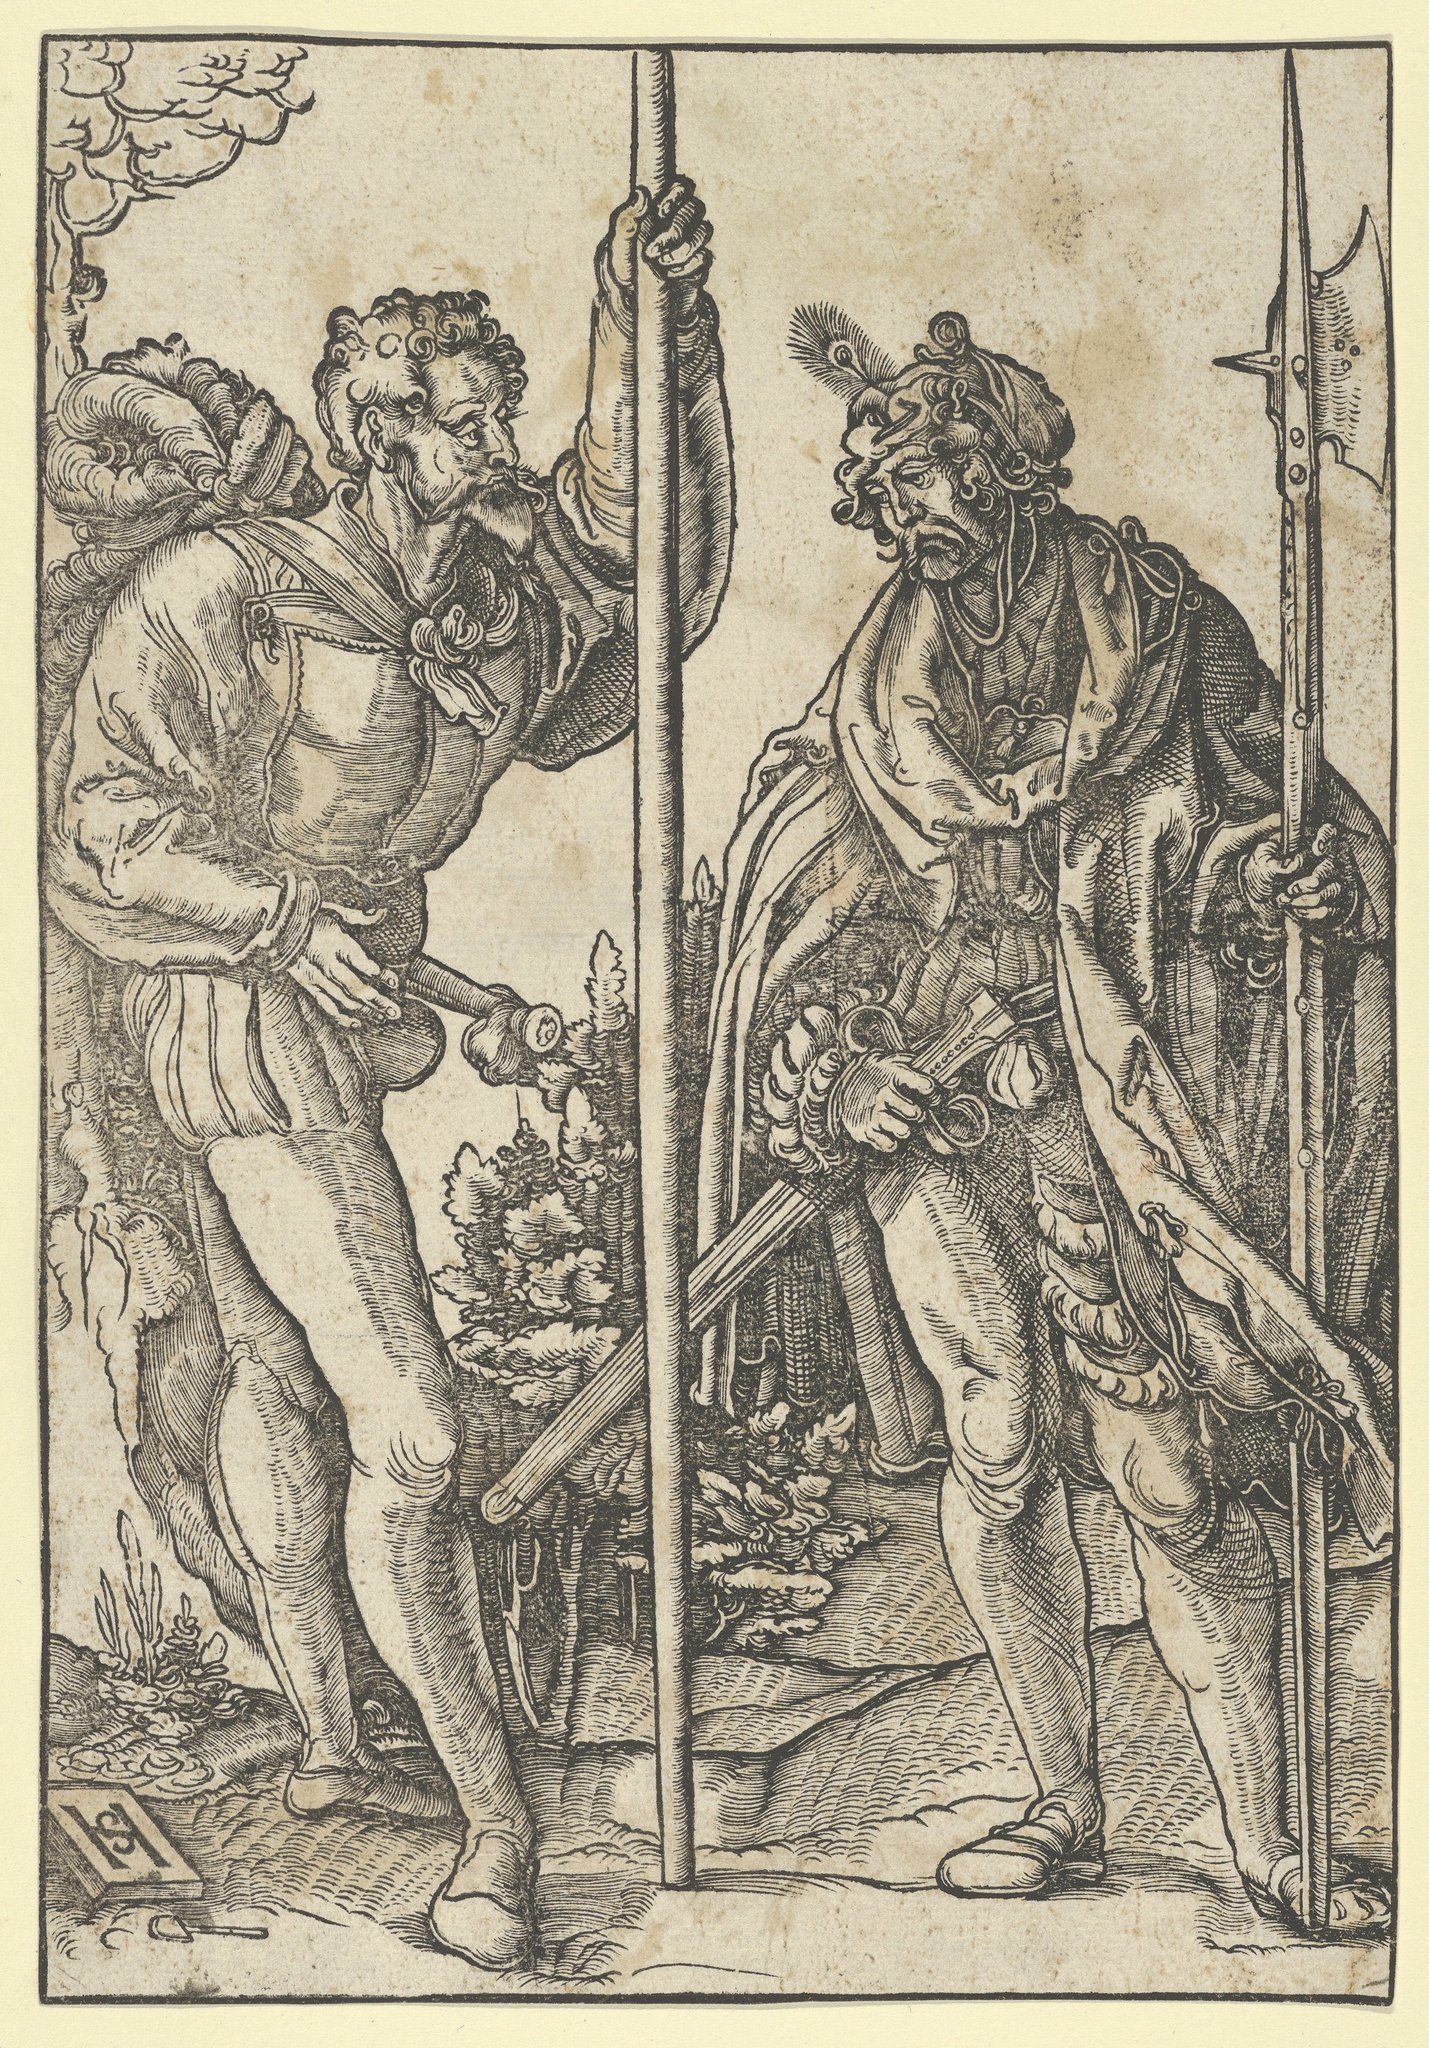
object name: print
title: Two Soldiers with Lance and Halberd Conversing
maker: hans schäufelein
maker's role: artist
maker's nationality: german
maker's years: 1480-1540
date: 1500-1540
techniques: woodcut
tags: soldiers,weapons,men